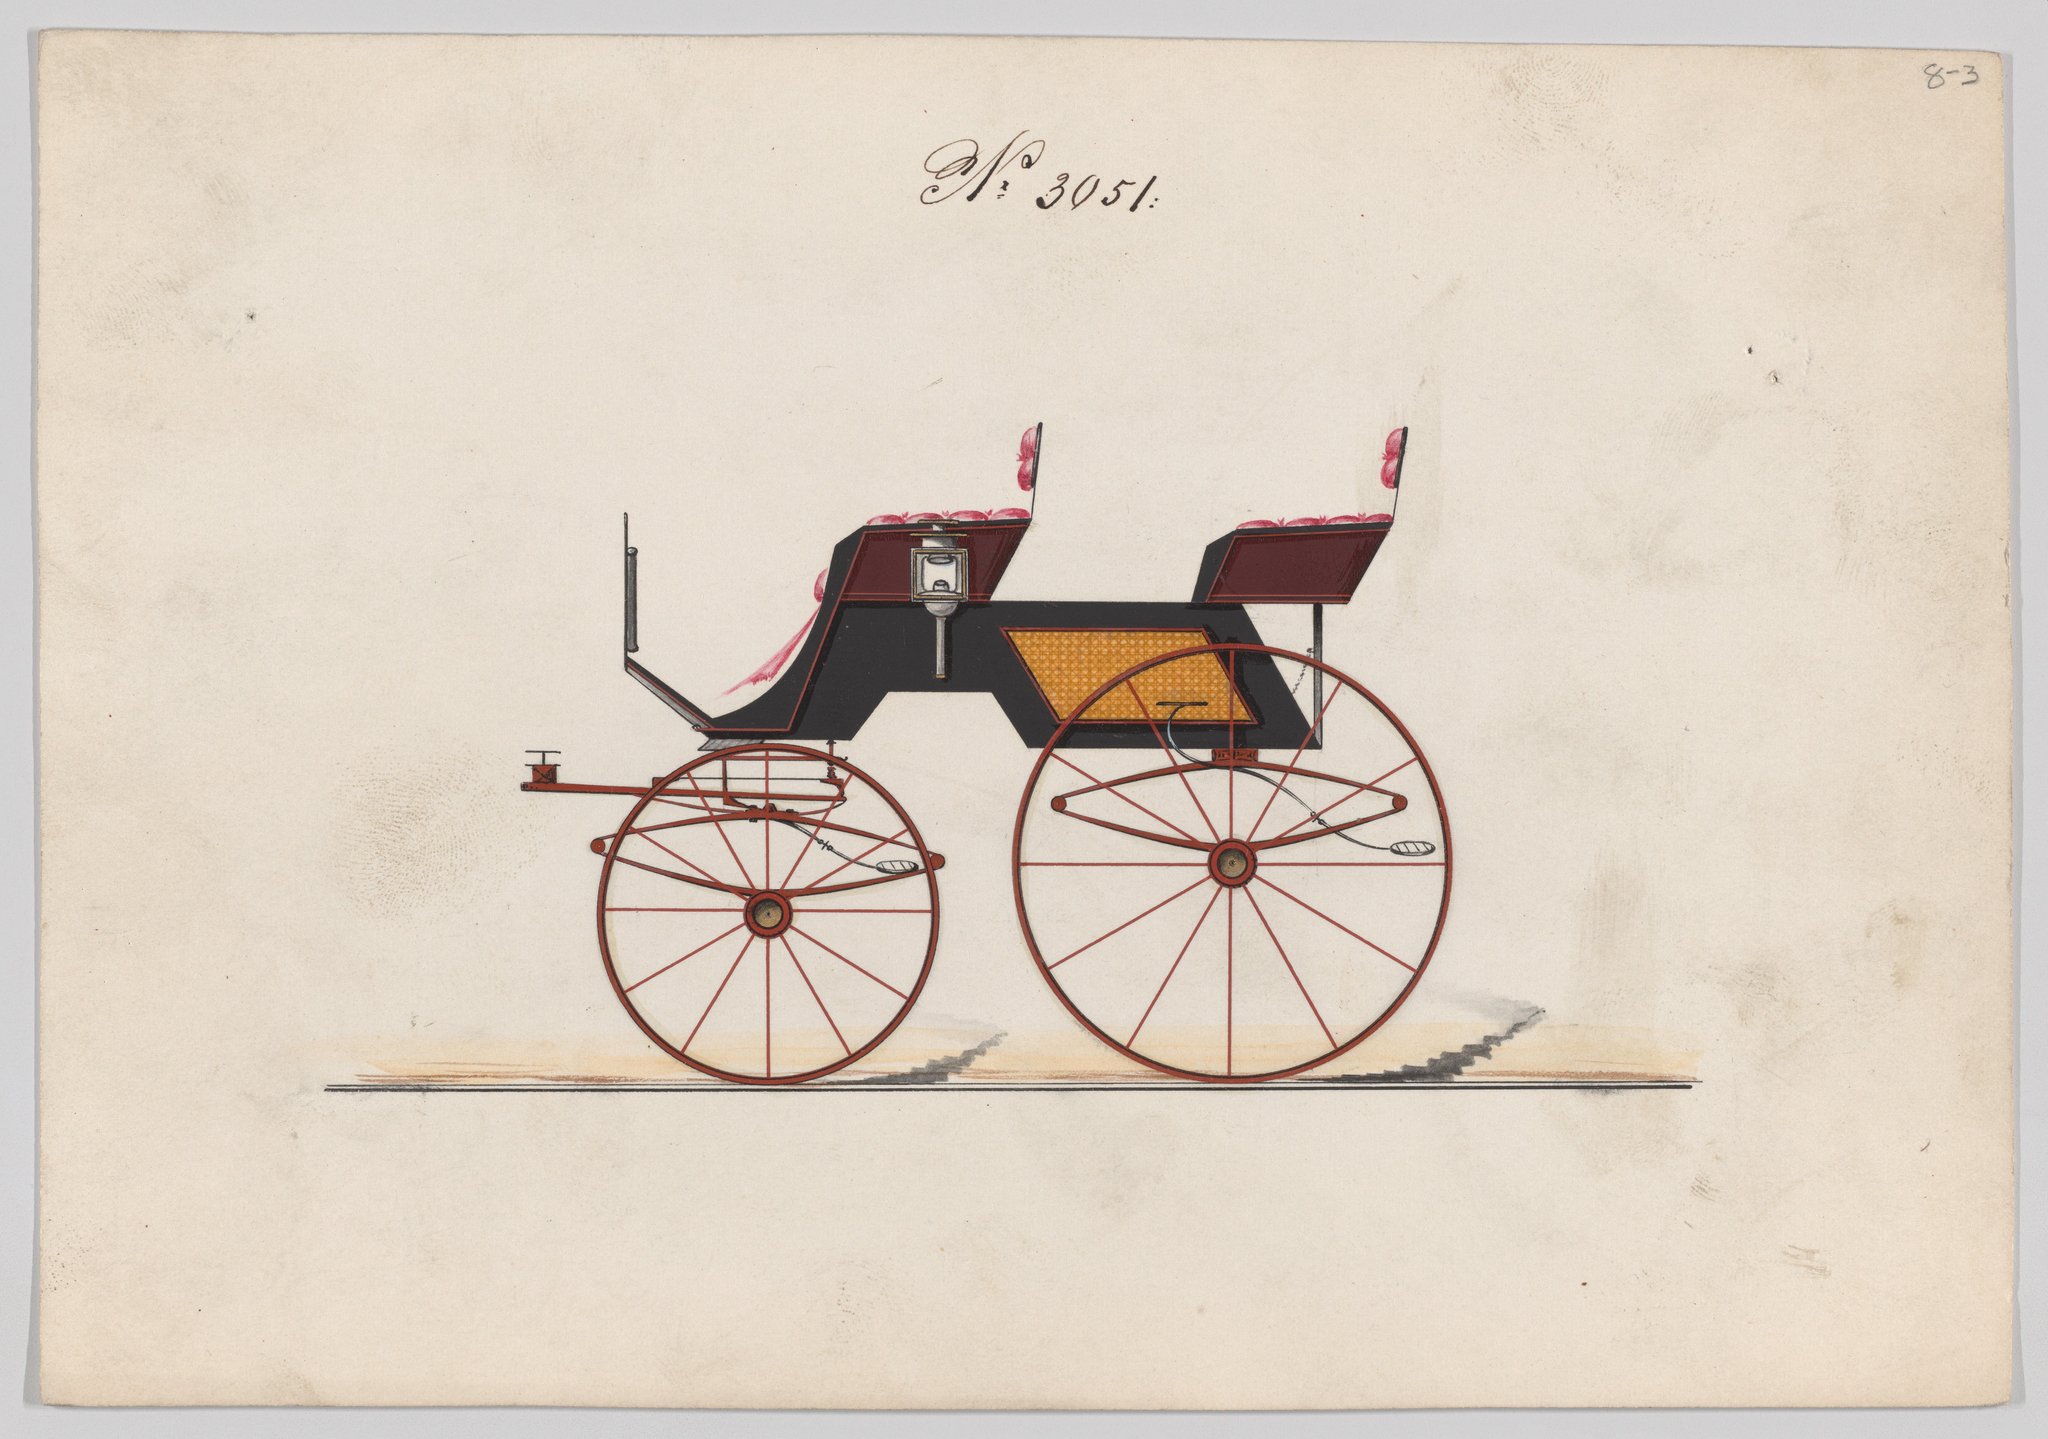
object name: drawing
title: Design for 4 seat Phaeton, no top, no. 3051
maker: brewster & co.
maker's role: manufacturer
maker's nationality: american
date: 1874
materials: gouache, gum arabic, ink, watercolor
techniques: pen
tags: carriages